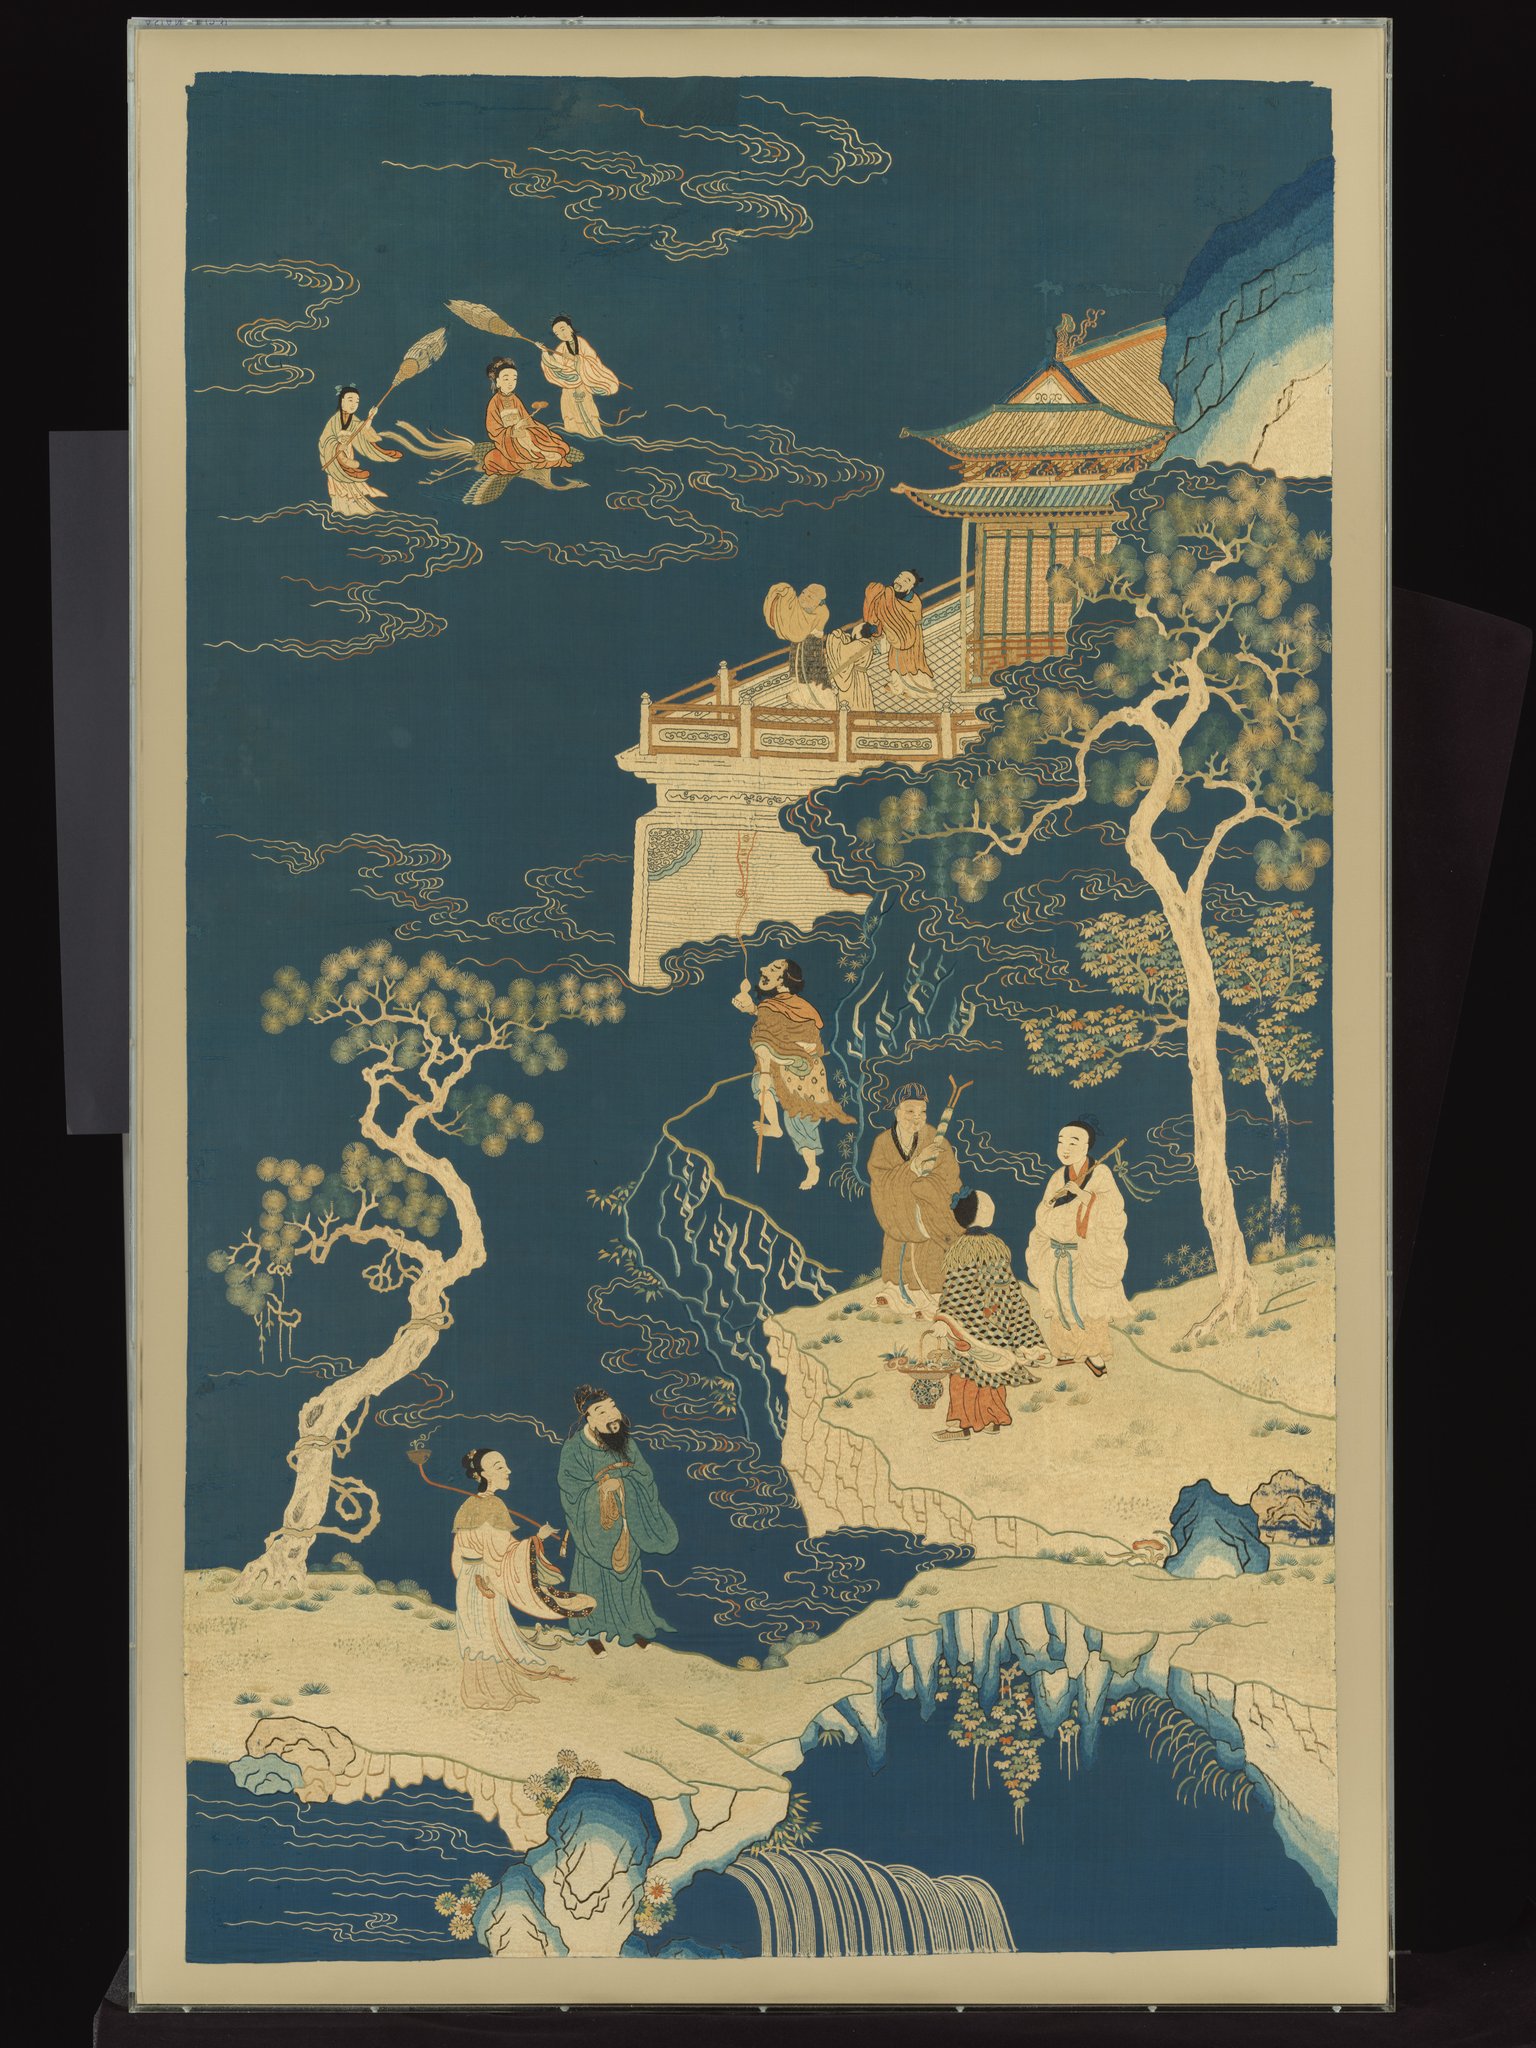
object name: panel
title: Panel with immortals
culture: chinese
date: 1701-1800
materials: metal thread, silk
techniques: embroidery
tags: birds,men,women,landscapes,pavilions